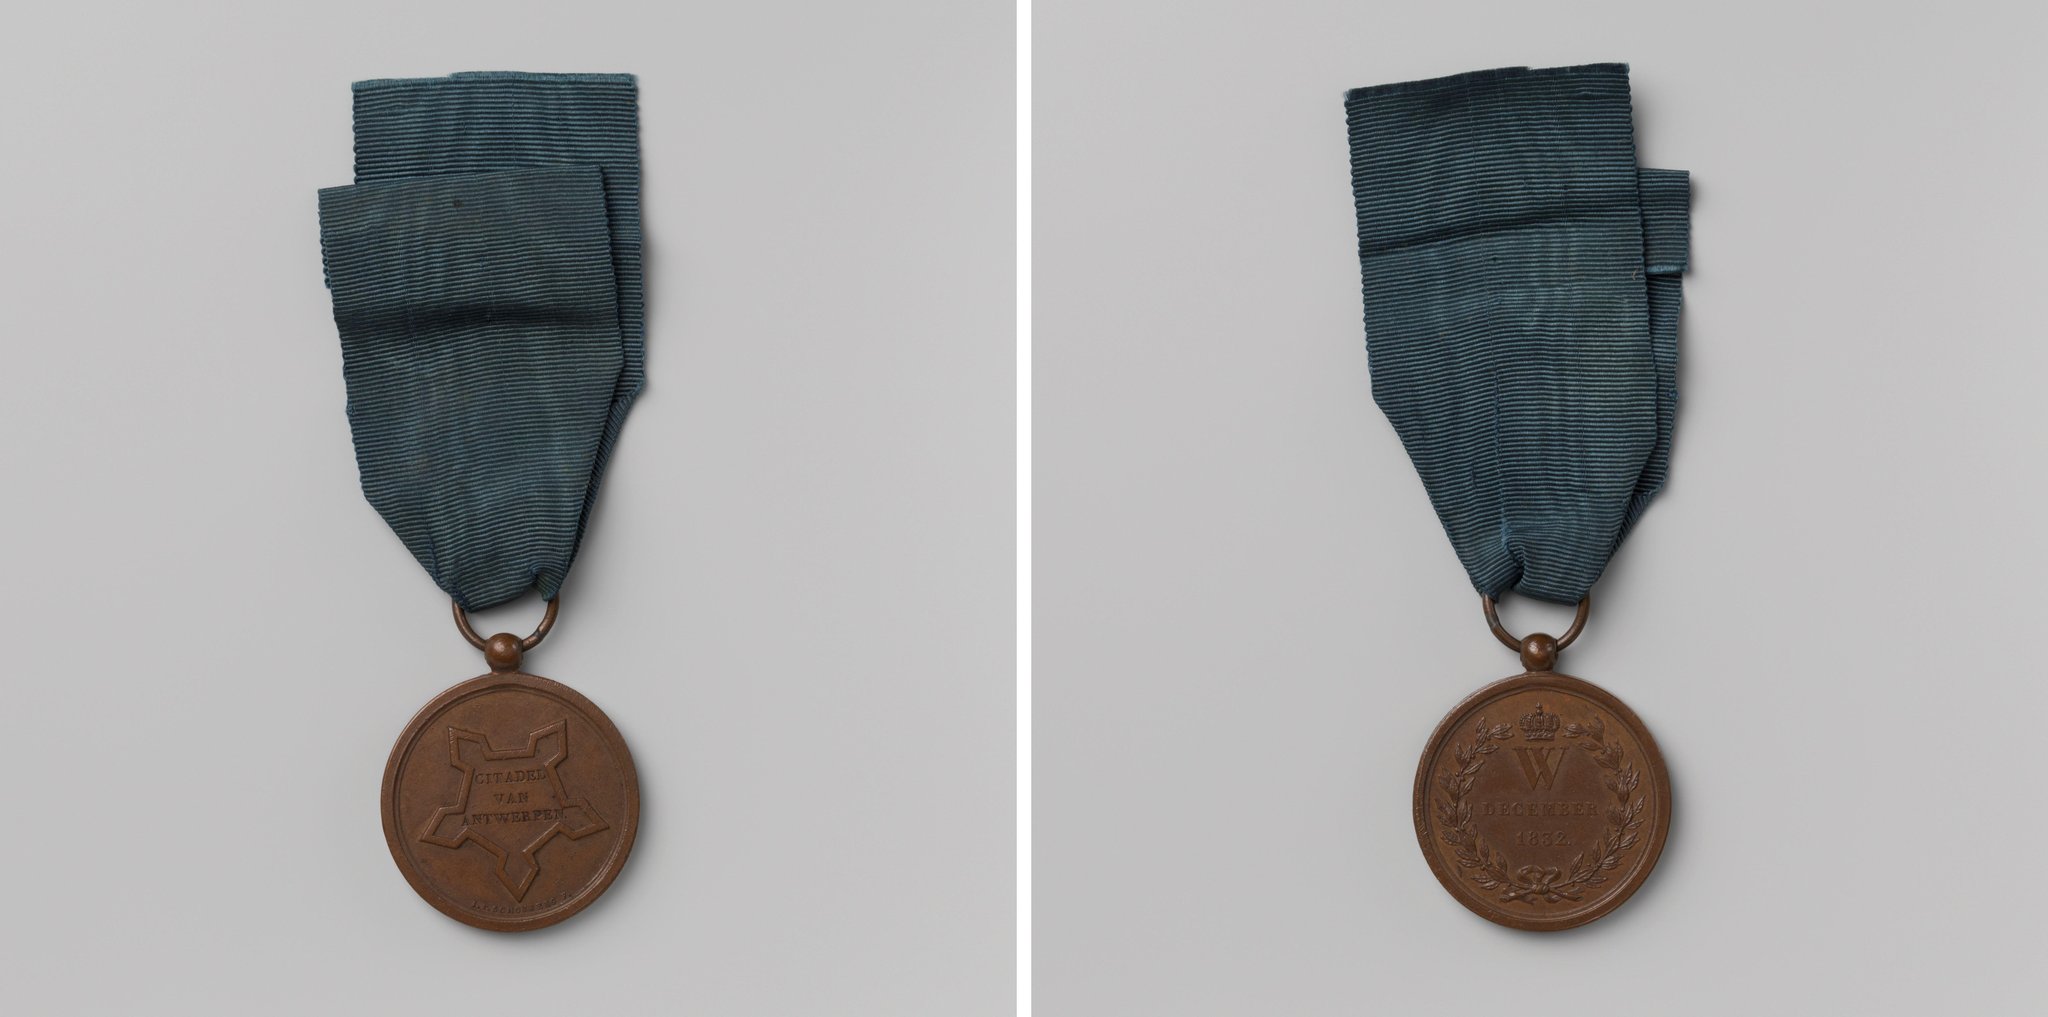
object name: insignia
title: Citadel van Antwerpen, draagteken uitgereikt aan de verdedigers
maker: johannis petrus schouberg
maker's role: die cutter, draughtsman, print maker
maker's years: 1798-1864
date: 1832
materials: bronze, textile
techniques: striking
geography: utrecht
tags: the hague, berlin, william i of the netherlands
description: Bronzen draagteken aan draagoog, draagring en Nassausch-blauw lint. Voorzijde: grondplan van citadel met daarin opschrift. Keerzijde: gekroonde letter W boven datum binnen krans van myrtetakken.